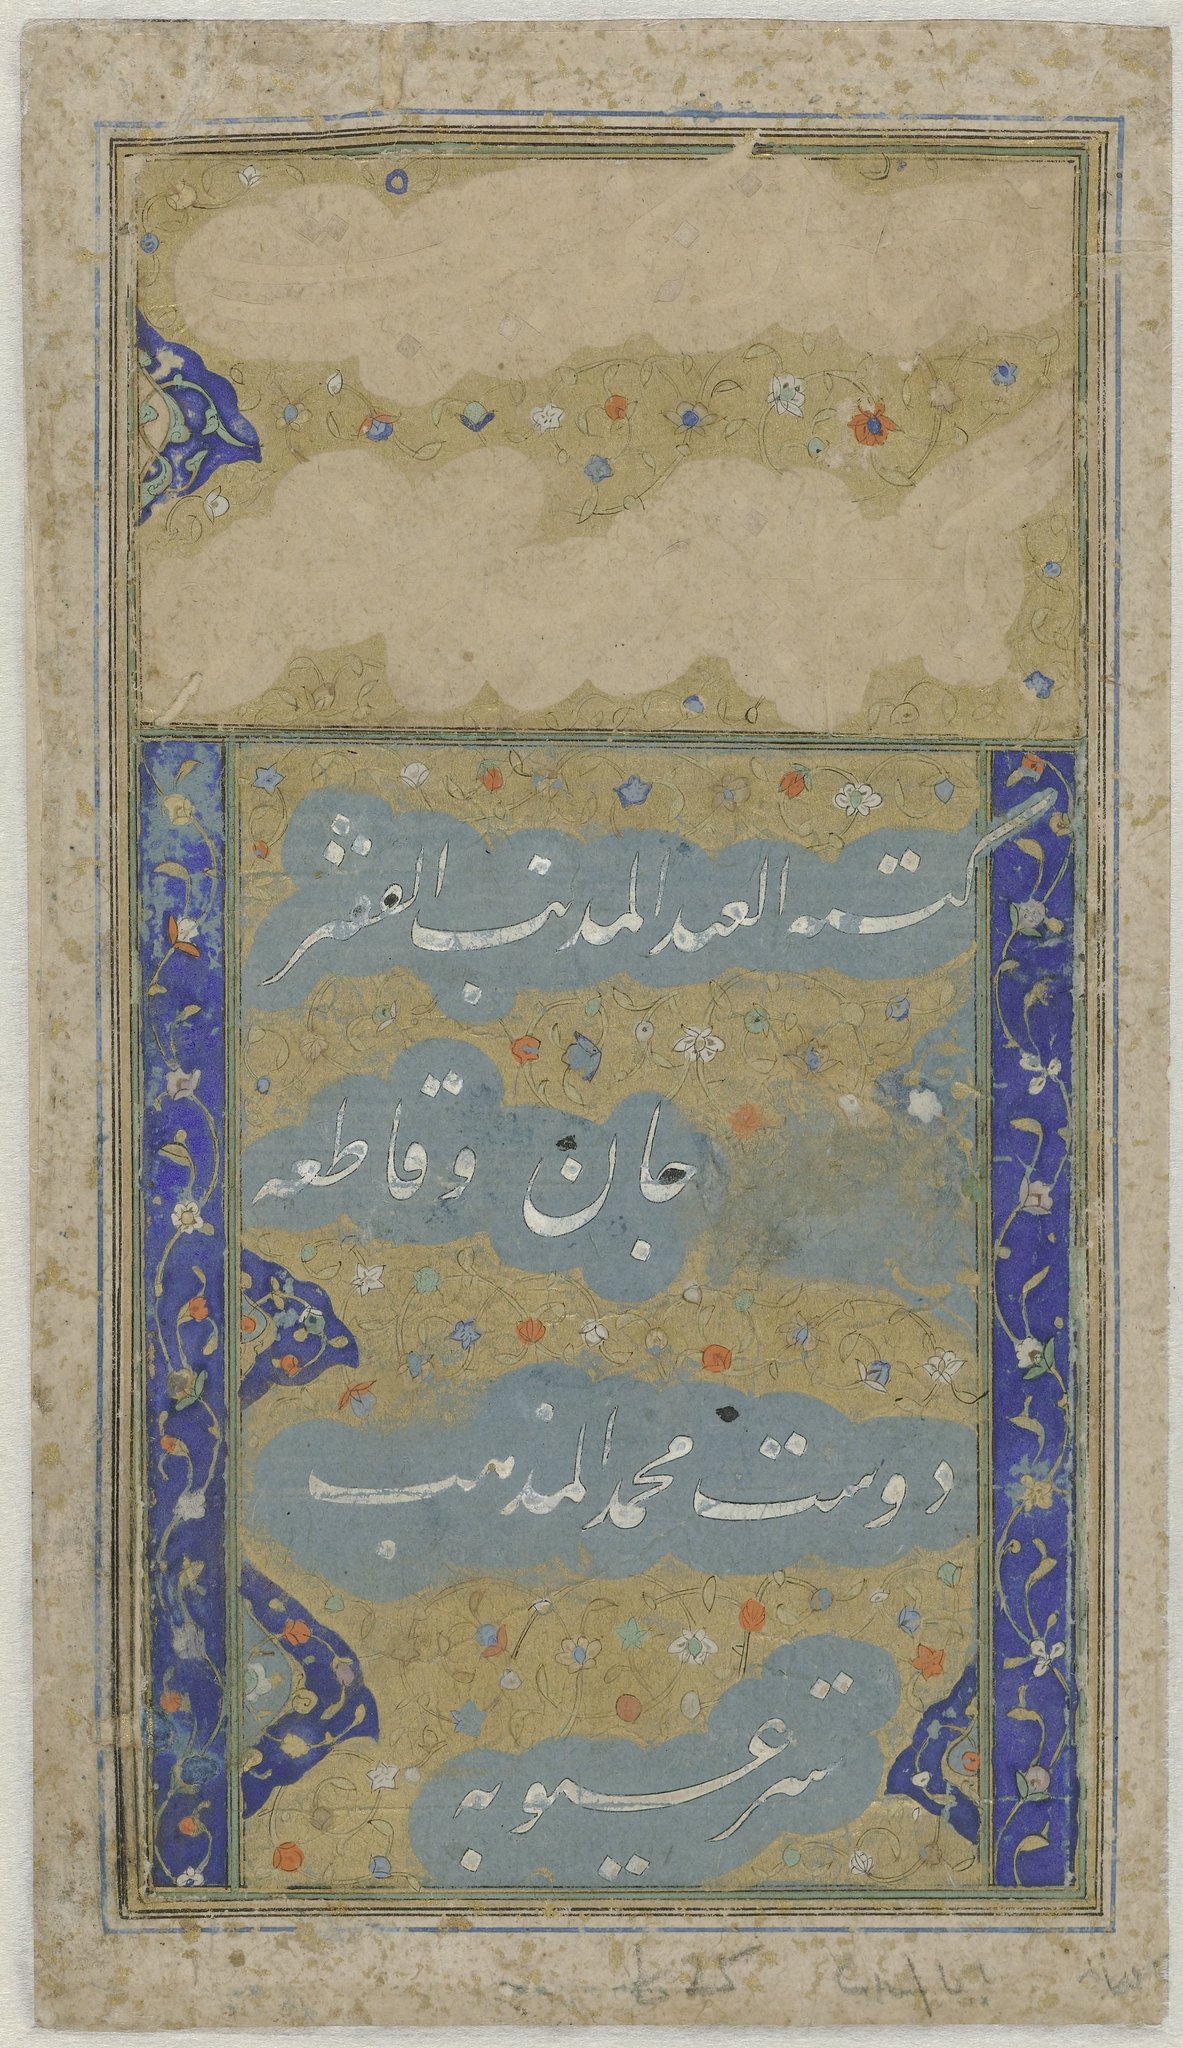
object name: calligraphy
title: Wit gekalligrafeerde tekst op hemelsblauwe wolkjes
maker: Anonymous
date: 1570-1590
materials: paper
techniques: brush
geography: iran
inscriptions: inscription: ‘.’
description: Wit gekalligrafeerde tekst op hemelsblauwe wolkjes tegen een achtergrond van een goudkleurig veld met gekleurde bloemmotieven, verticaal afgebiesd in donkerblauw met gouden ranken; het bovenste deel van de kalligrafie is apart opgeplakt en grotendeels verdwenen. Langs het (beschadigde) tekstblad zijn smalle stroken met kaderlijnen geplakt en daarlangs het restgedeelte van het blad met bloemmotieven in goud omslingerd door lichtbruine ranken tegen een hemelsblauwe achtergrond.